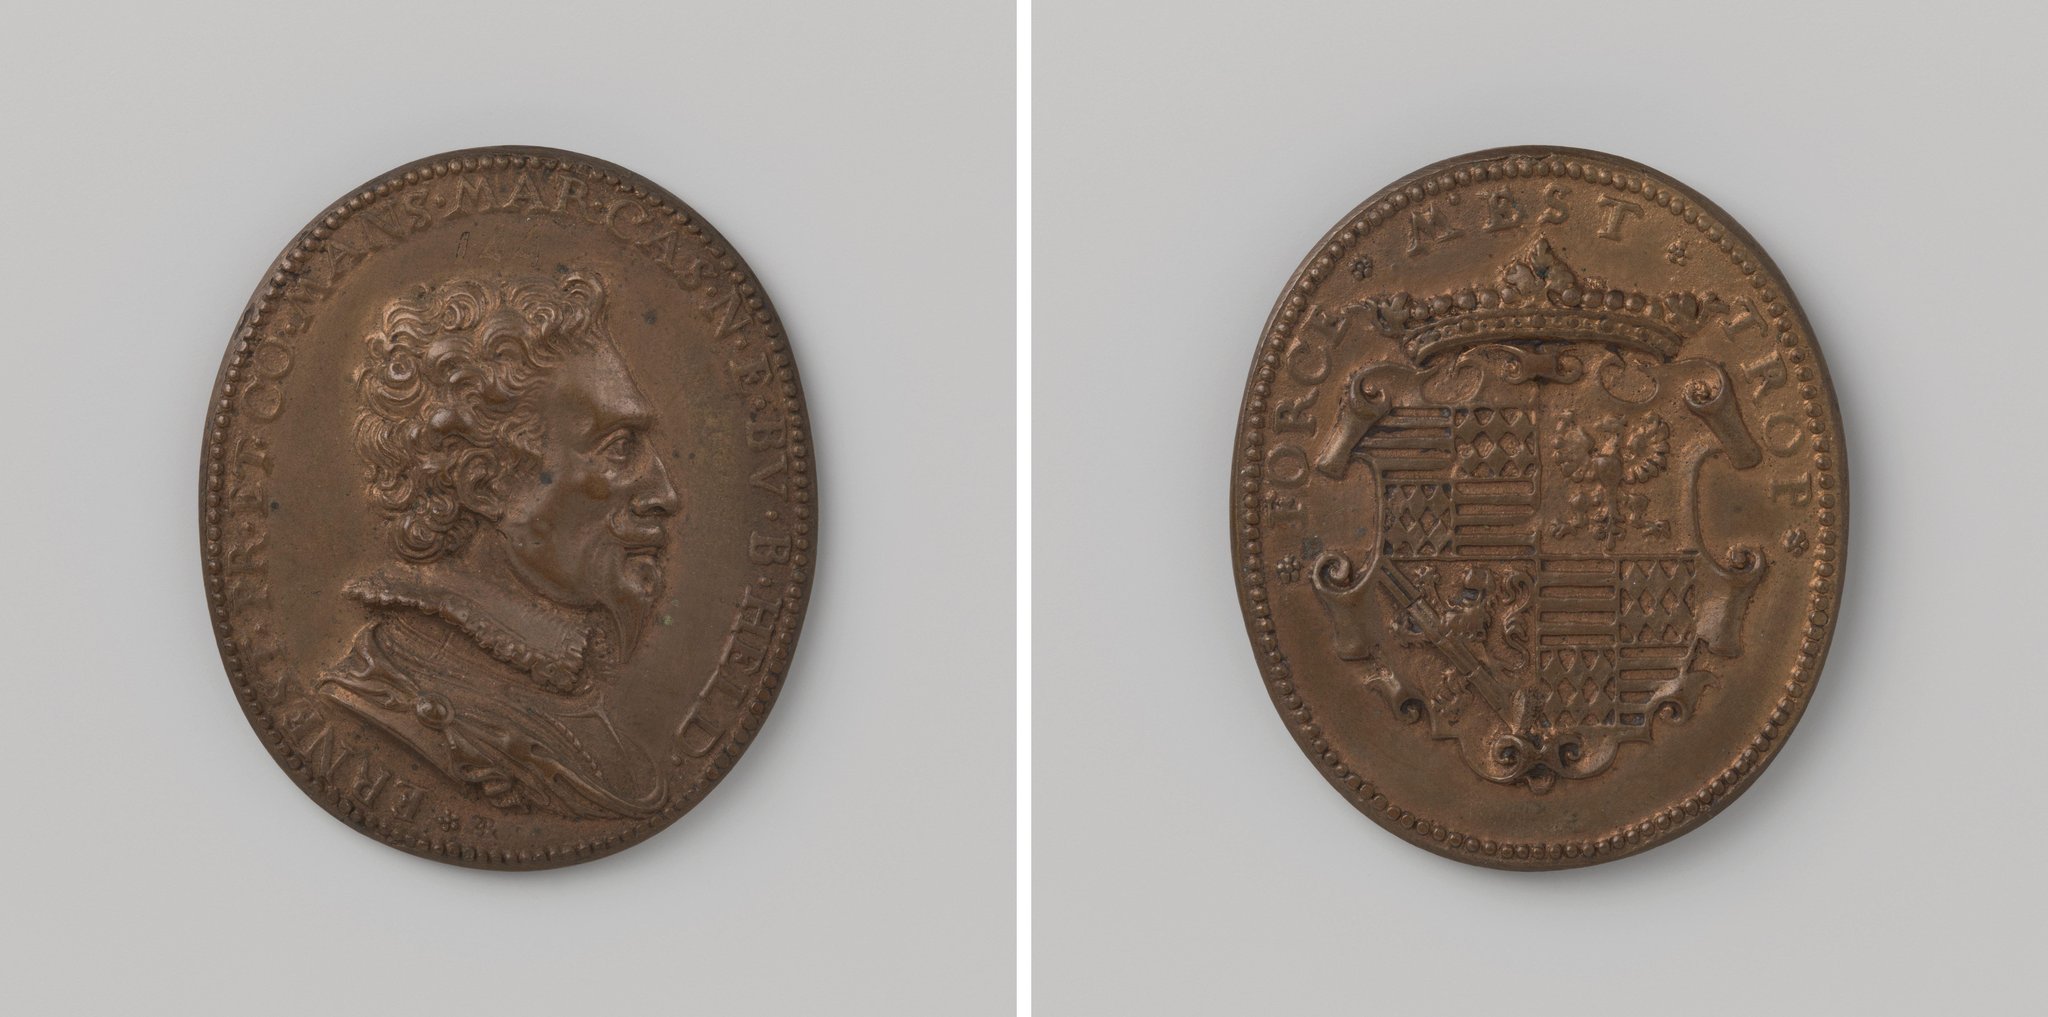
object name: history medal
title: Ernst, graaf van Mansfeld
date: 1622-1626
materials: bronze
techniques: striking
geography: the hague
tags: earl, peter ernst von mansfeld (graaf)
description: Bronzen ovale penning. Voorzijde: borststuk man binnen omschrift. Keerzijde: gekroond wapenschild binnen omschrift;